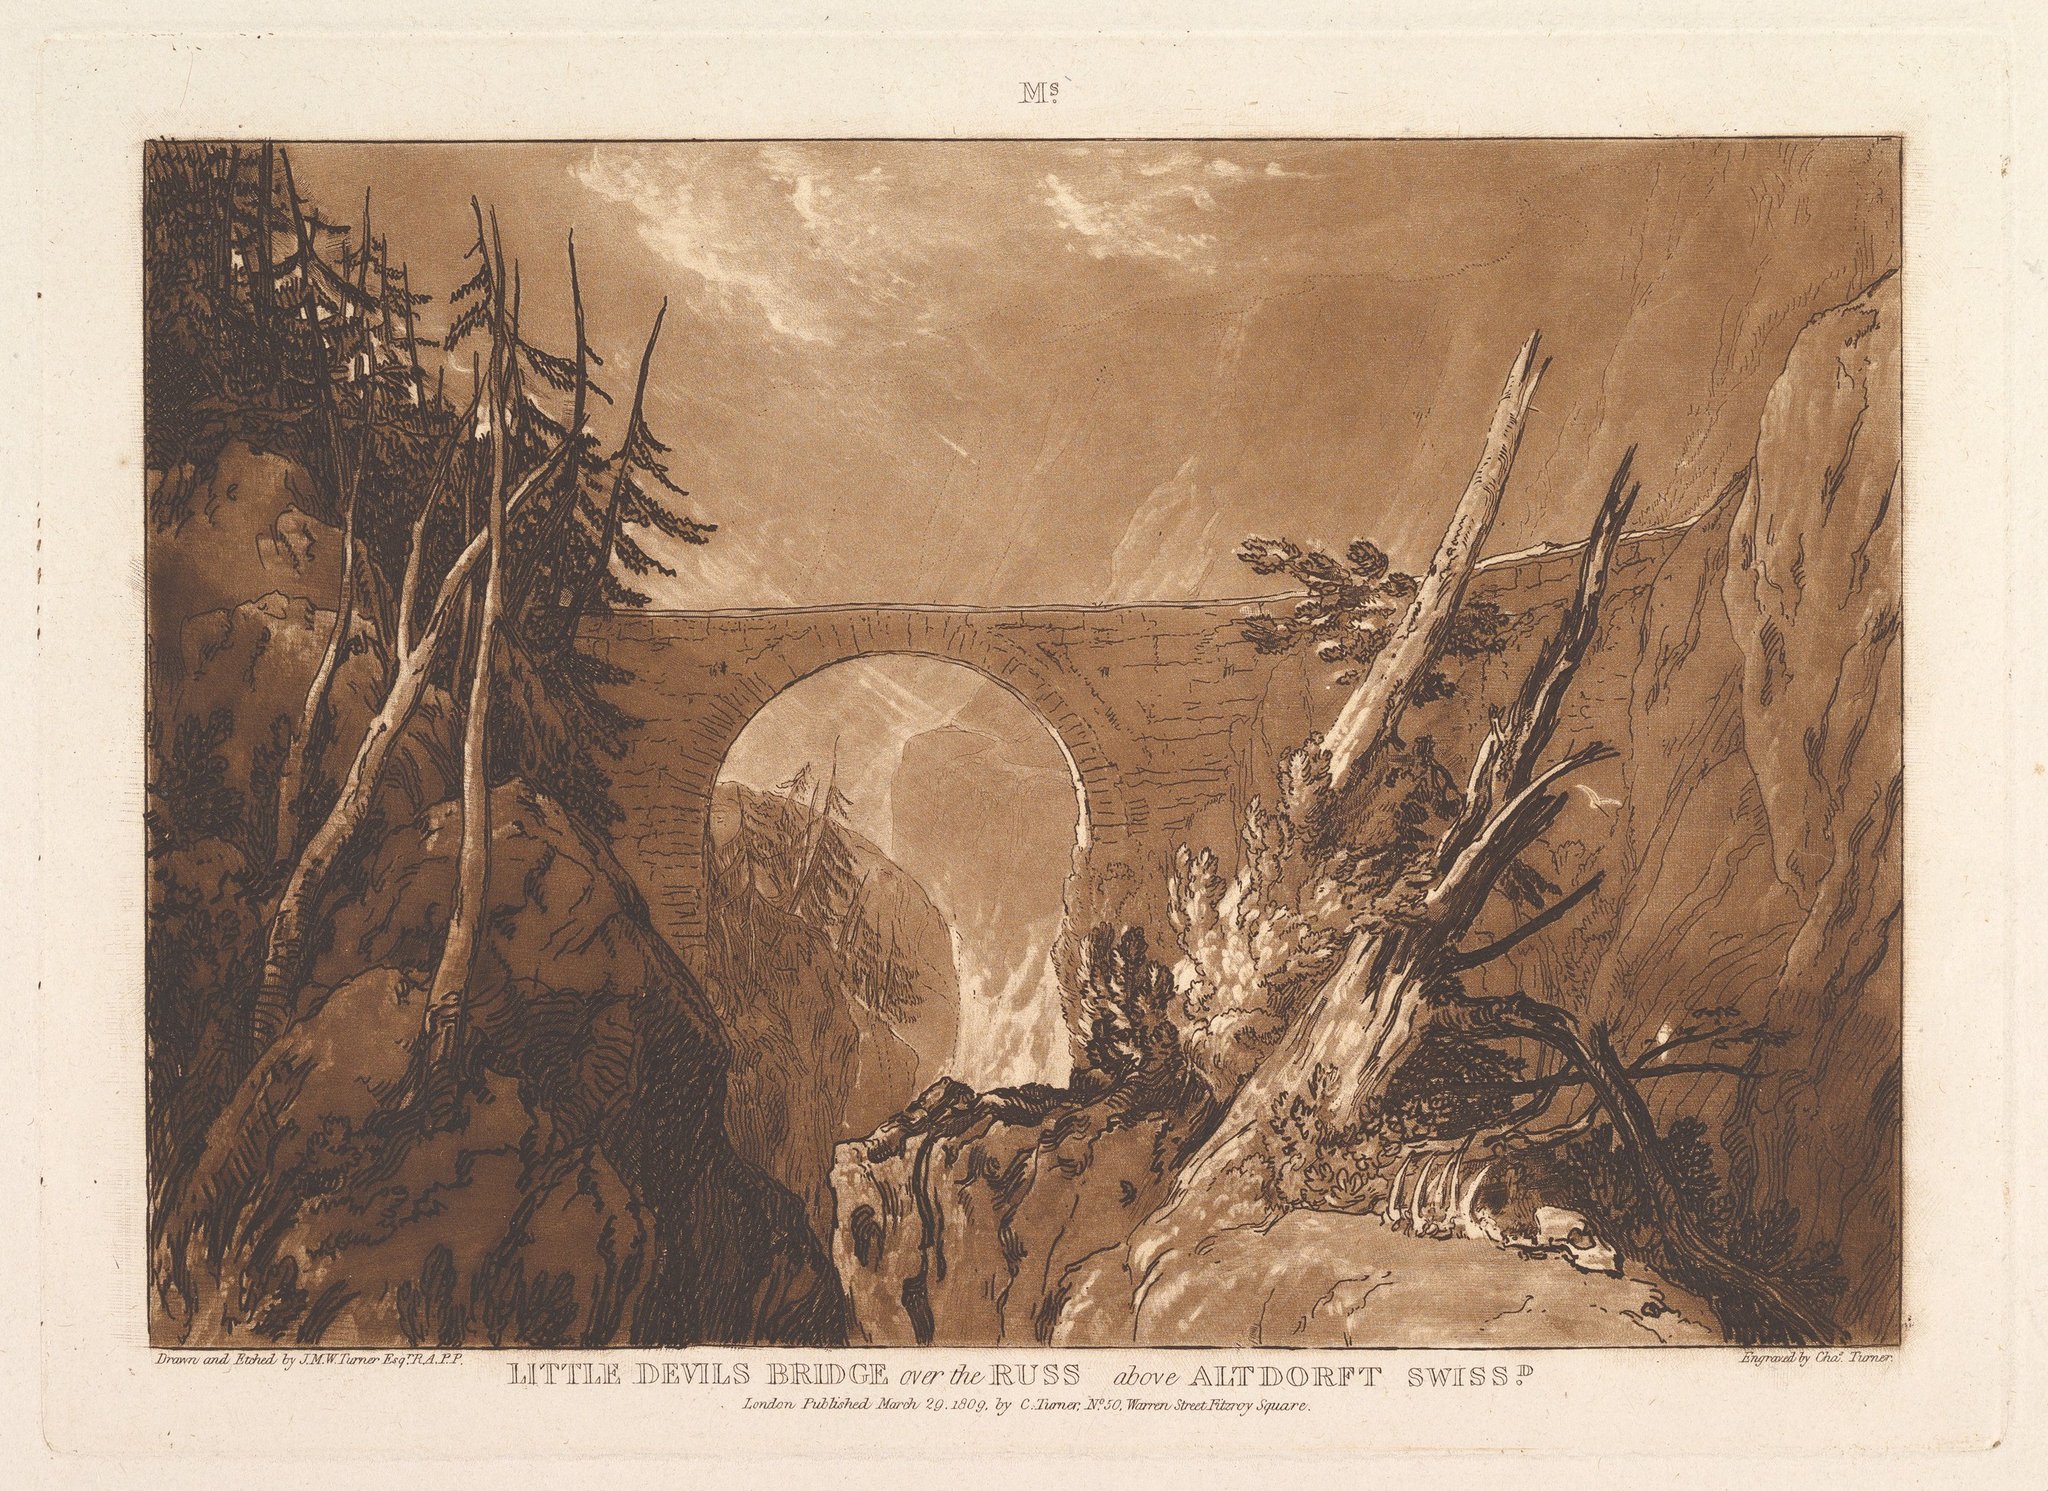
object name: print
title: Little Devil's Bridge over the Russ, above Altdorft, Switzerland (Liber Studiorum, part IV, plate 19)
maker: joseph mallord william turner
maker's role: artist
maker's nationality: british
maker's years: 1775-1851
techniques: etching, mezzotint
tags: bridges